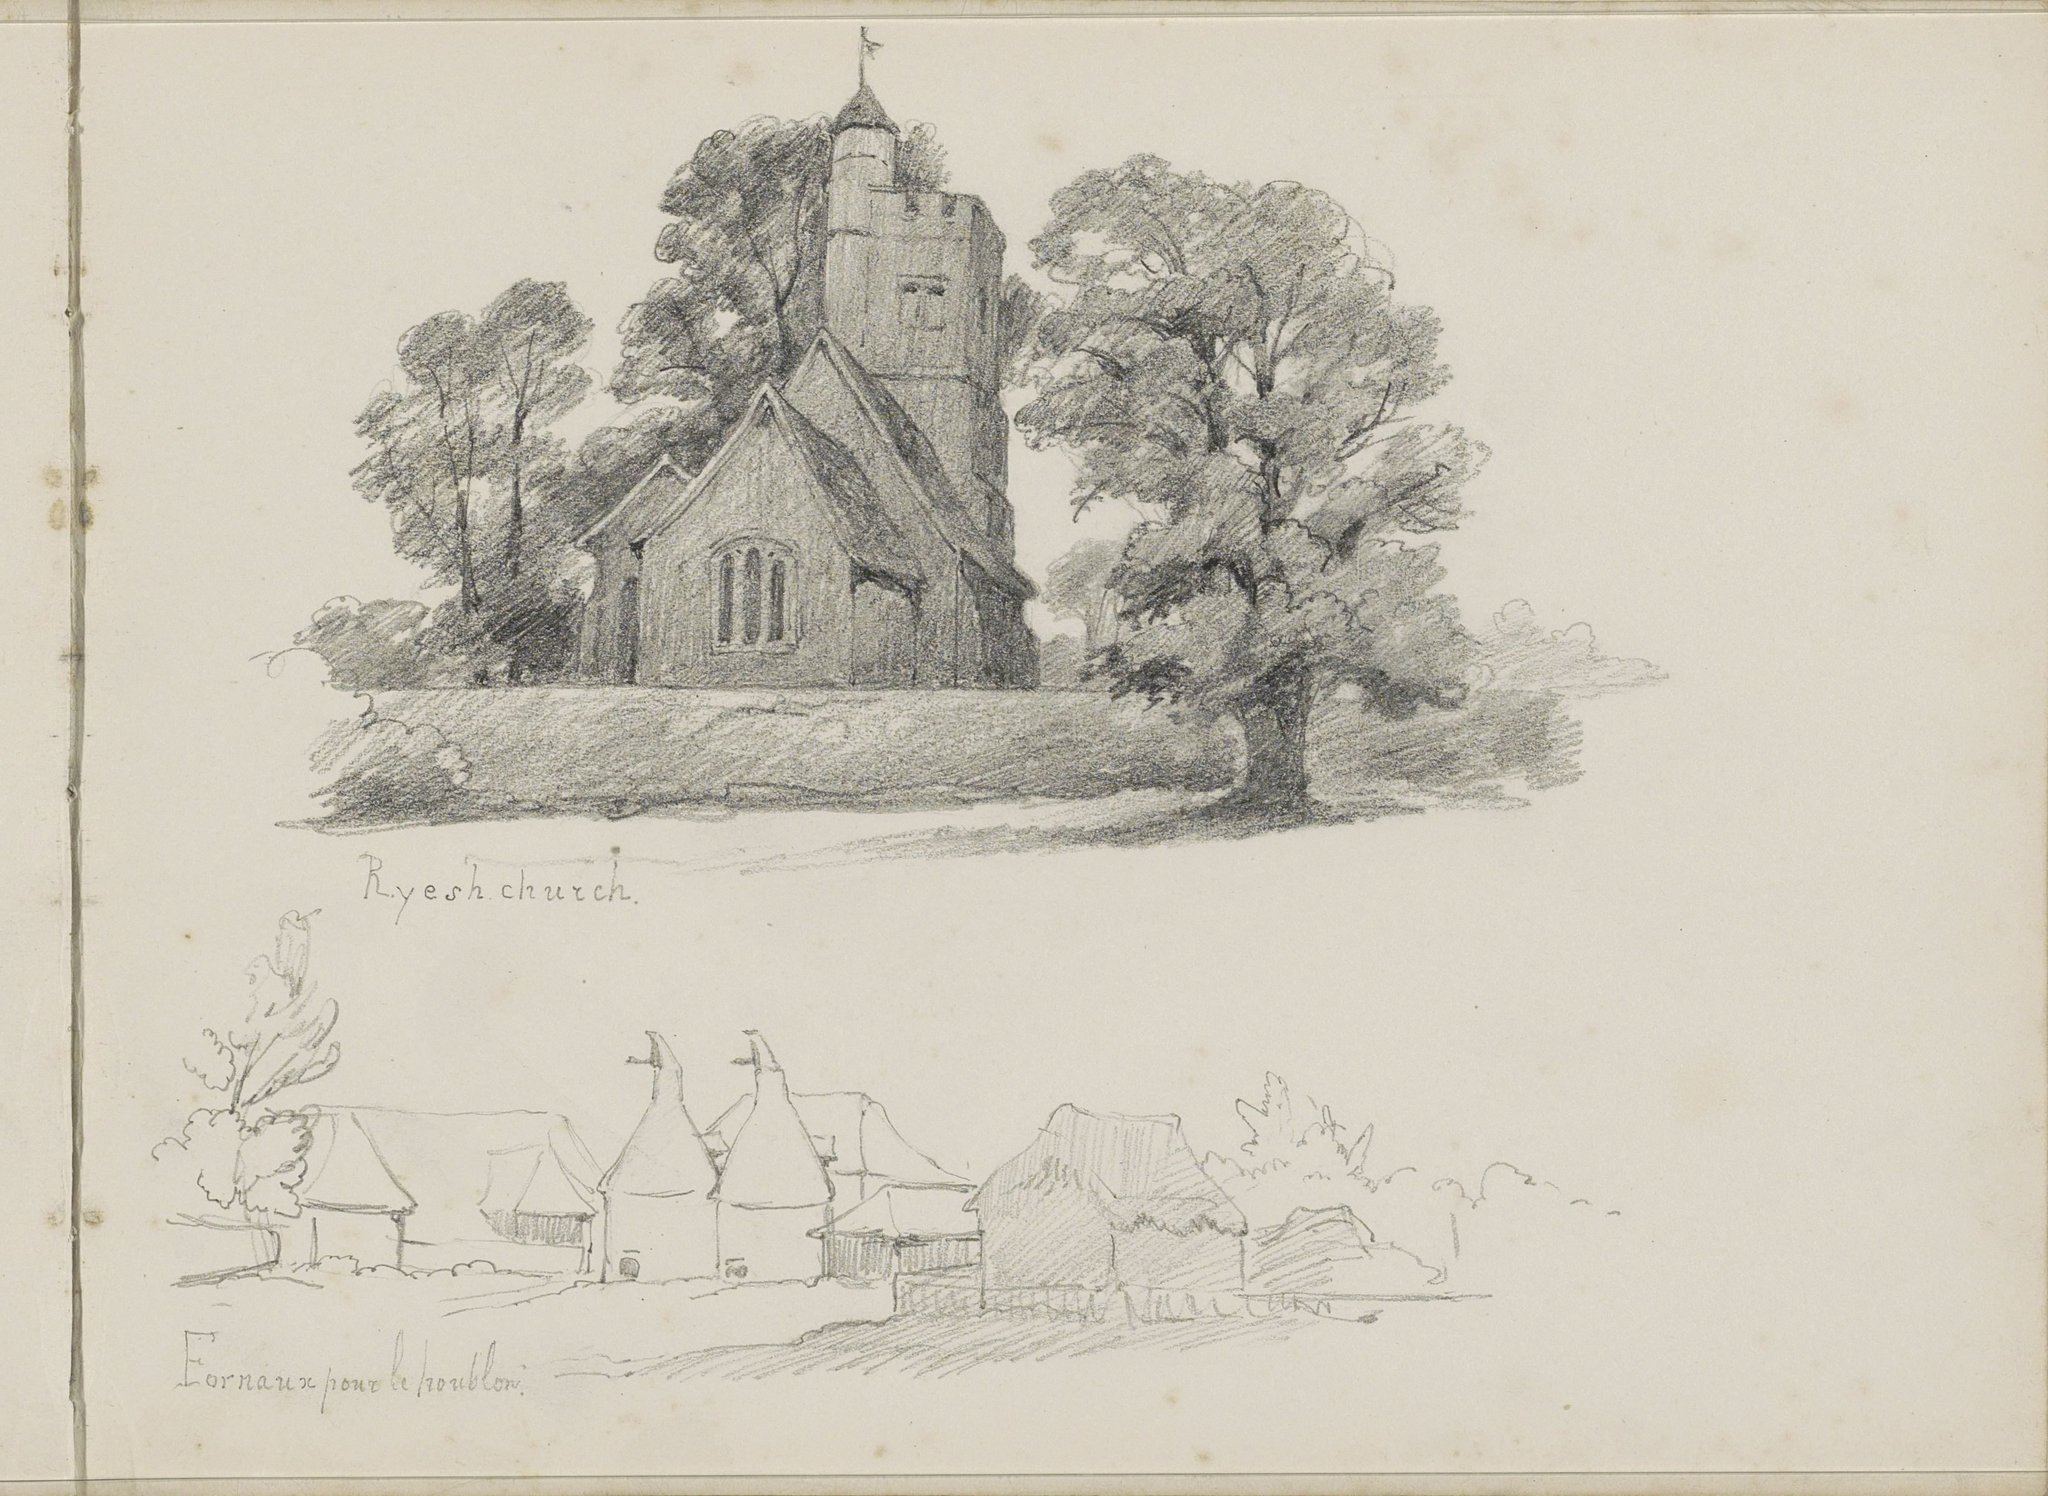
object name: sketchbook leaf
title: Exterieur van een kerk en hopovens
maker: gerrit postma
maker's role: draughtsman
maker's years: 1819-1894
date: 1858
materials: paper, pencil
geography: england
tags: church (exterior), exterior of industrial structures, factories, england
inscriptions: annotation: ‘Ryesh church./ Fornaux pour le houblon’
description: Blad 39 recto uit een schetsboek met 52 bladen.